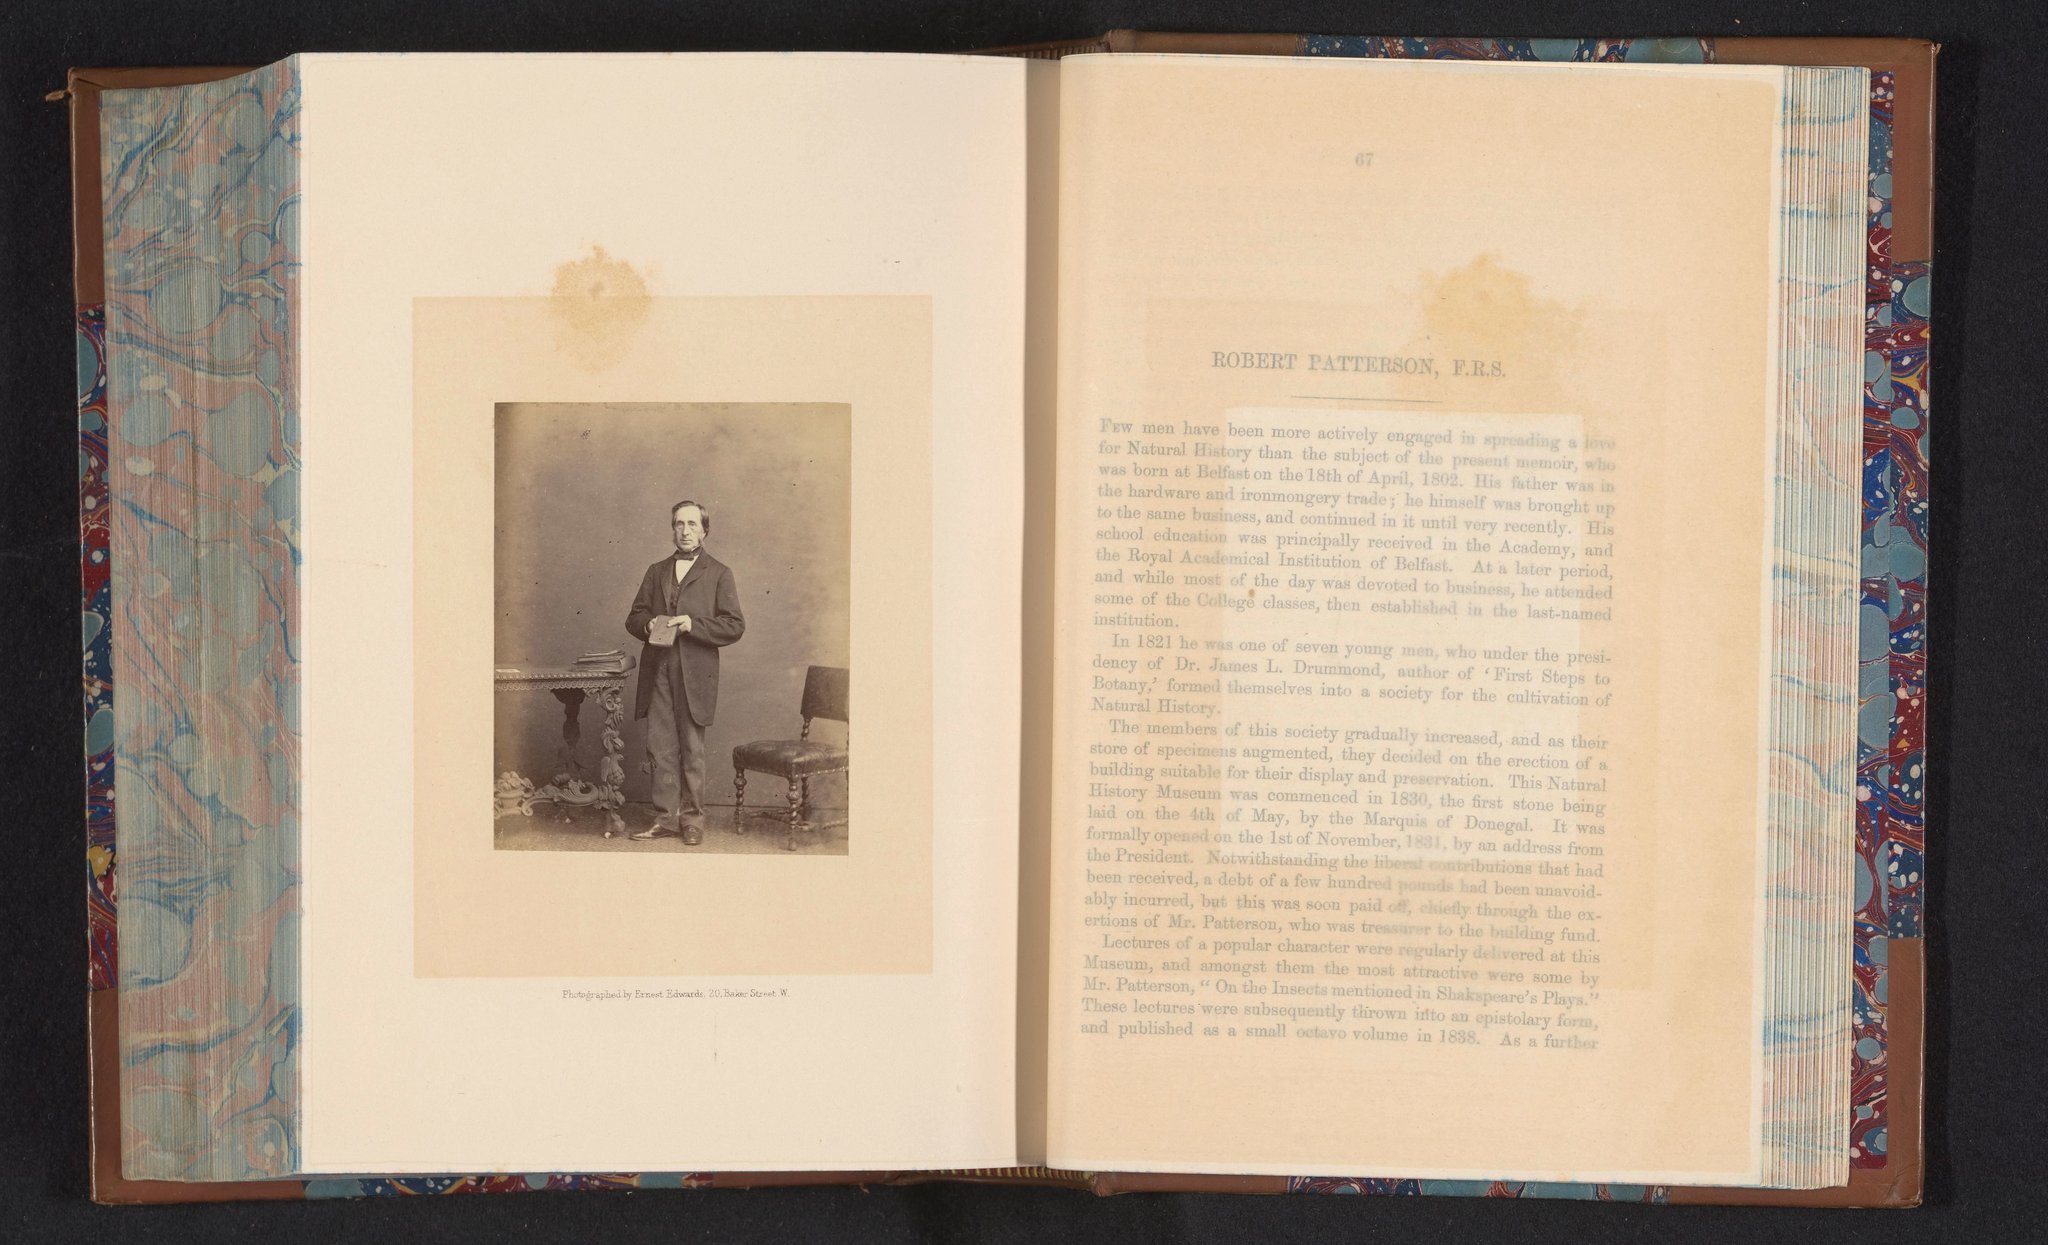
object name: photograph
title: Portret van Robert Patterson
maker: ernest edwards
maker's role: fotograaf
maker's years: 1837-1903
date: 1853-1867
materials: photographic support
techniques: albumen print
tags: adult man, historical persons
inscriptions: name: ‘Photographed by Ernest Edwards, 20, Baker Street. W.’